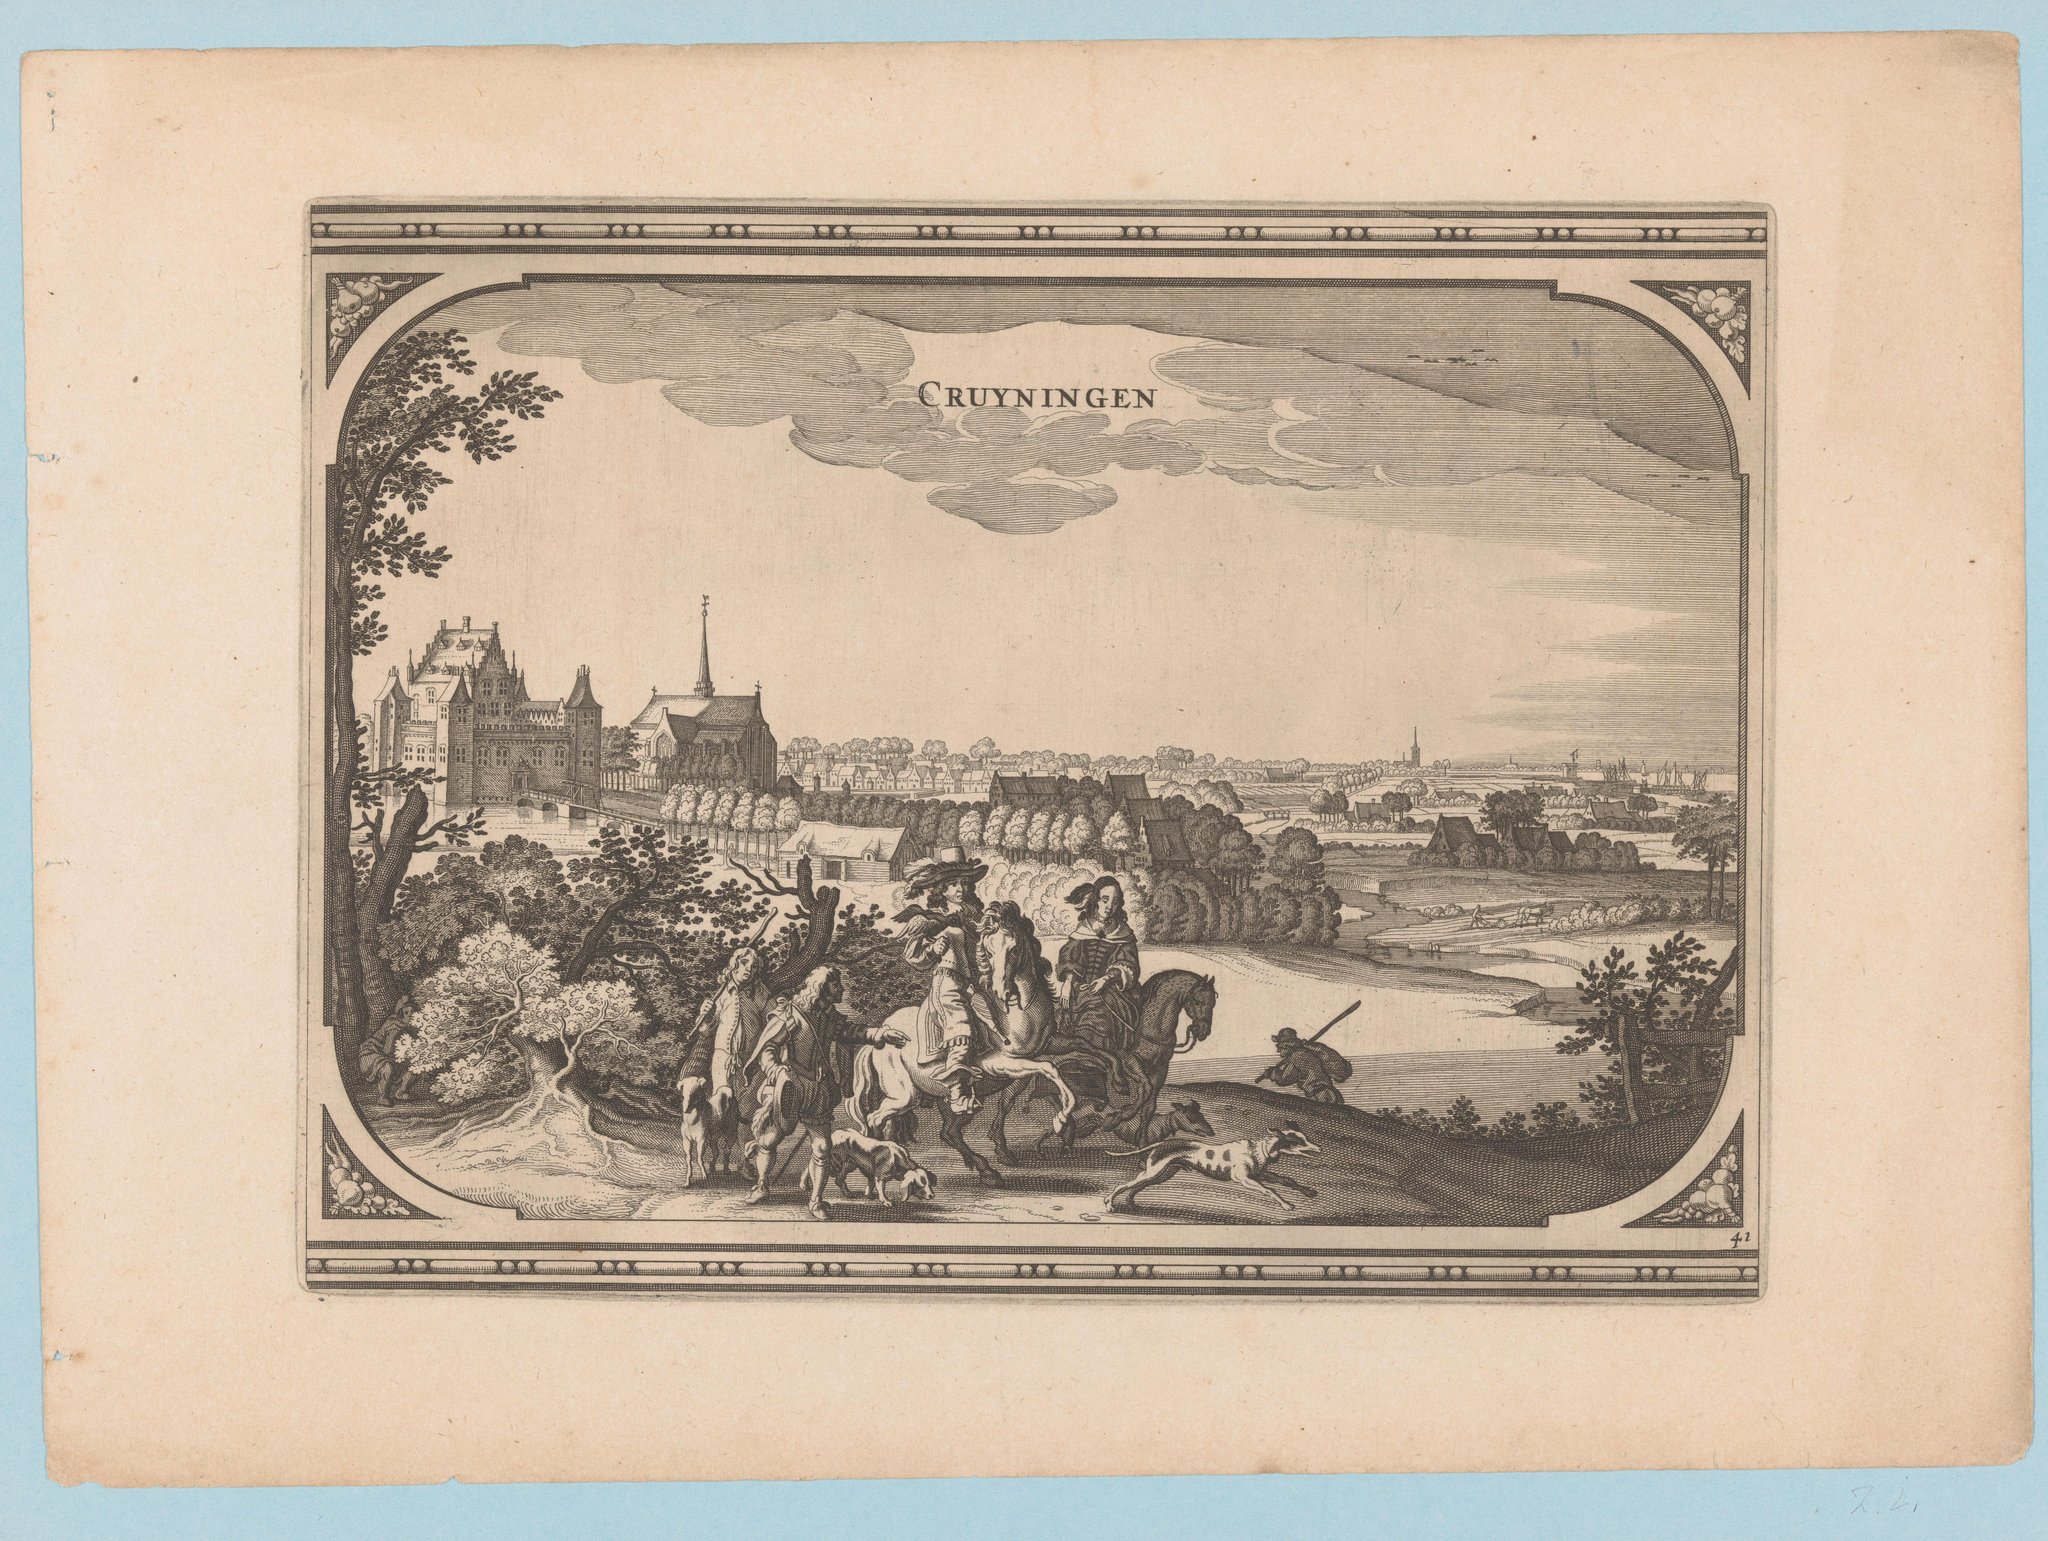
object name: print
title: Speculum Zelandiae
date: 1656-1657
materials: paper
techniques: engraving, etching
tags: prospect of village, silhouette of village, castle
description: Prent verschenen in: Schut, Pieter Hendricksz.Theatrum praecipuarum urbium ducatus Brababtiae necnon comitatum Flandriae et Zelandiae. Amsterdam: Nicolaes Visscher, 1657. En in: Caerten en Steden van Brabant, Vlaenderen ende Zeelandt, Middelburg. Middelburg: Zacharias Roman; Amsterdam: Nicolaes Visscher, 1656. Verschillende staten van prenten zijn gebruikt in andere uitgaven van 'Speculum Zelandiae' en in andere publicaties uitgegeven door Zacharias Roman en Nicolaes Visscher (I). Verwarring rondom de datering kan ontstaan door het feit dat de prenten uit 'Speculum Zelandiae' ook voorkomen in eerder uitgegeven publicaties, waar ze later in zijn ingebonden. Zo komen prenten uitgegeven door Roman/Visscher voor in sommige exemplaren van: Boxhorn, Marcus Zuerius van. Chroniick van Zeelandt (…). 2 dln. Middelburg: Zacharias Roman, 1644. De door weduwe (Joachim) Ottens en Zoonen uitgegeven prenten zijn later ingebonden in sommige exemplaren van: Smallegange, Mattheus. Nieuwe Cronyk van Zeeland (…). Middelburg en Amsterdam: Johannes Meertens en Abraham van Someren, 1696.